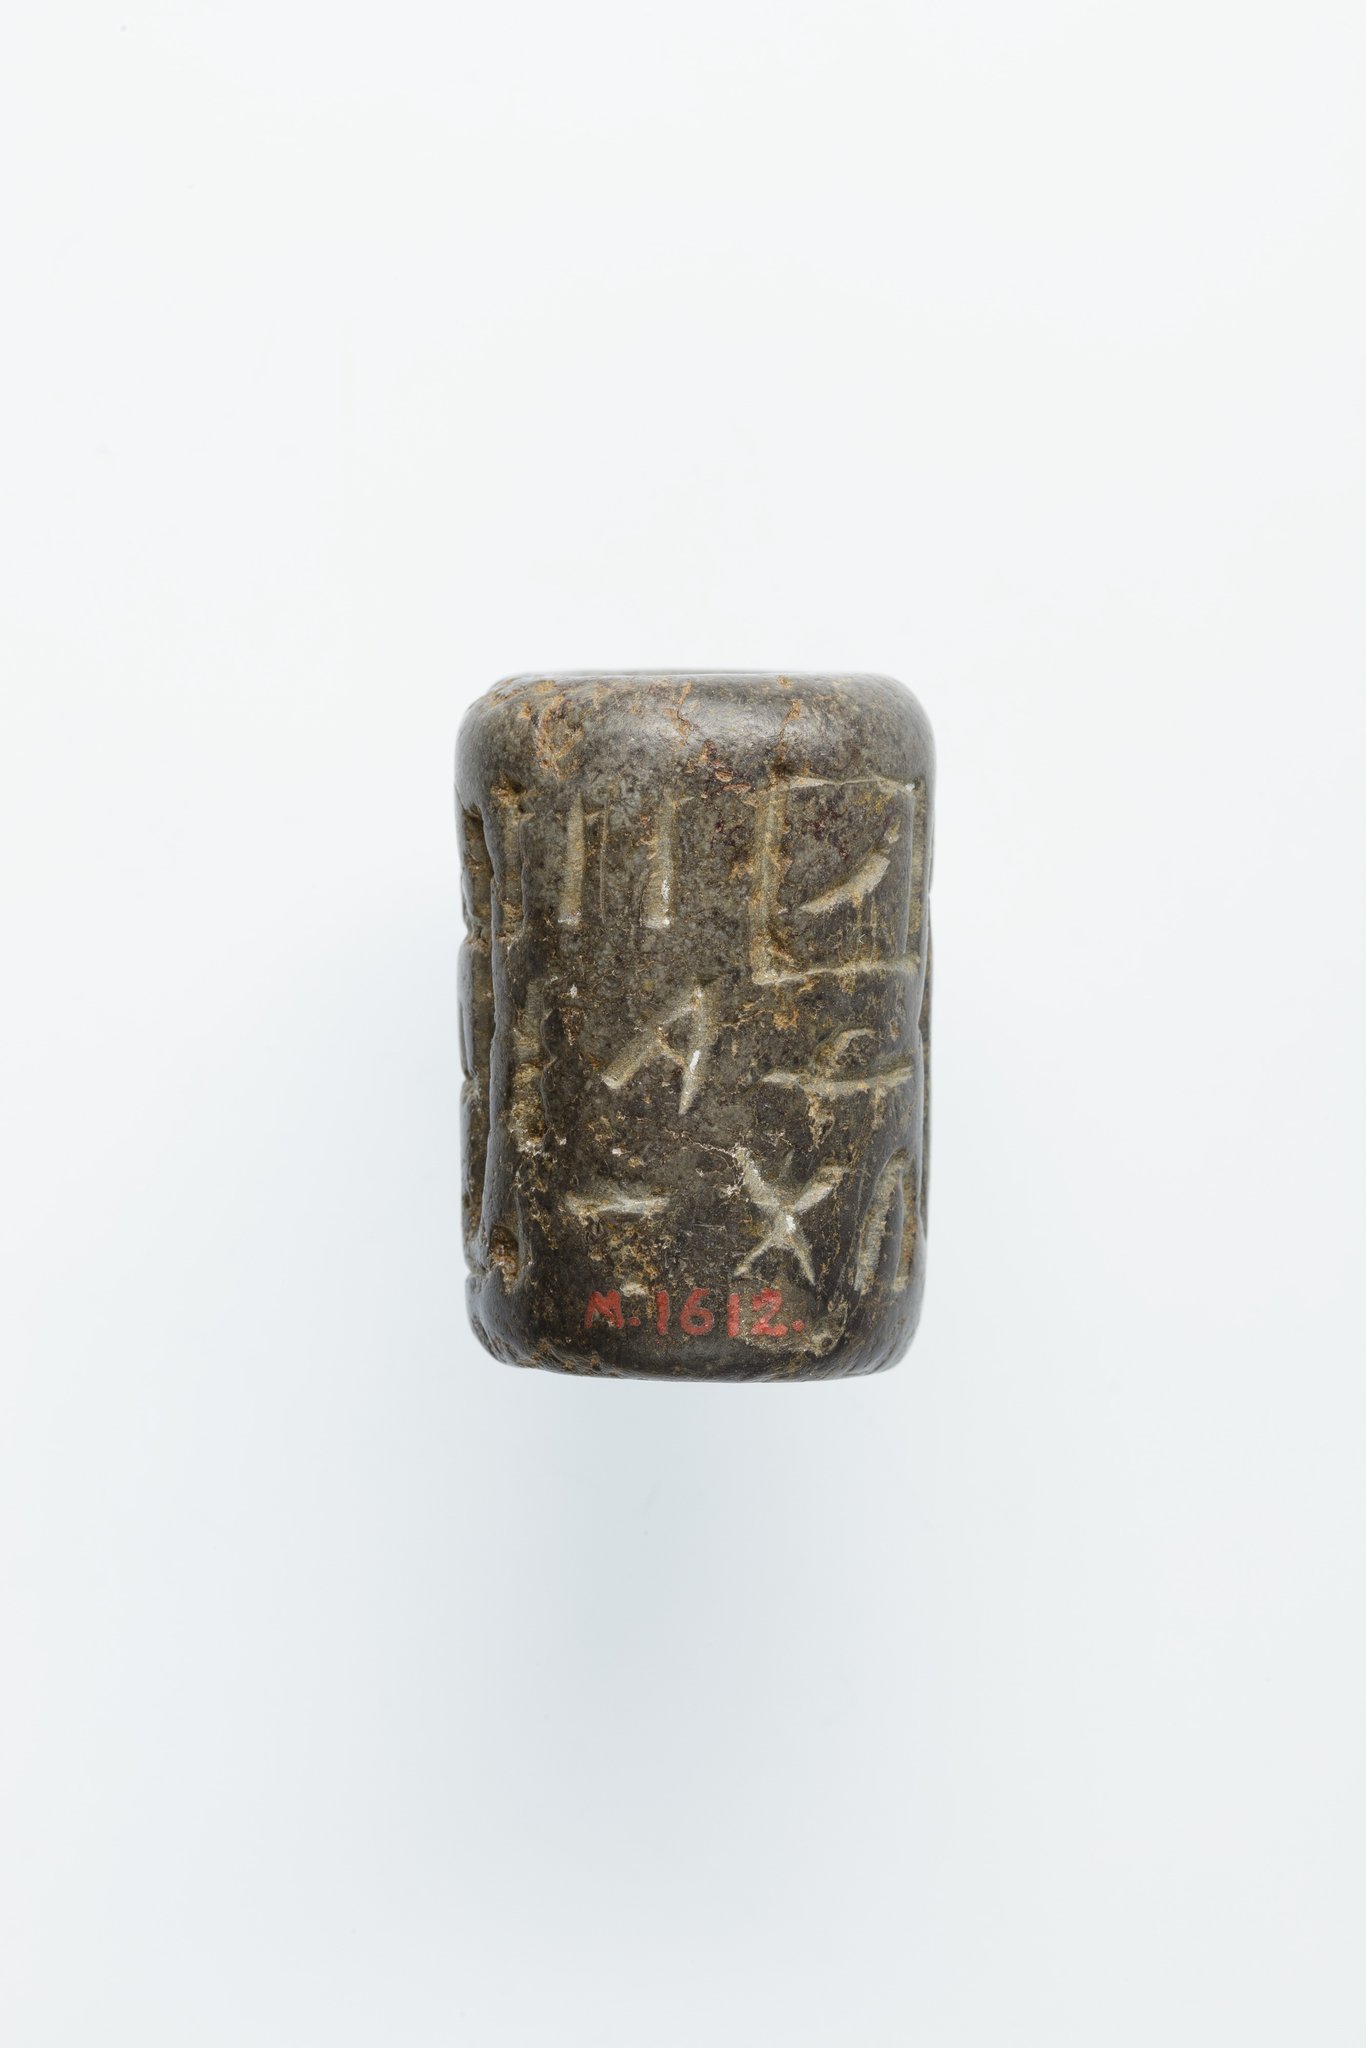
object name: cylinder seal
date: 2649-2100 BCE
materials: stone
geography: egypt